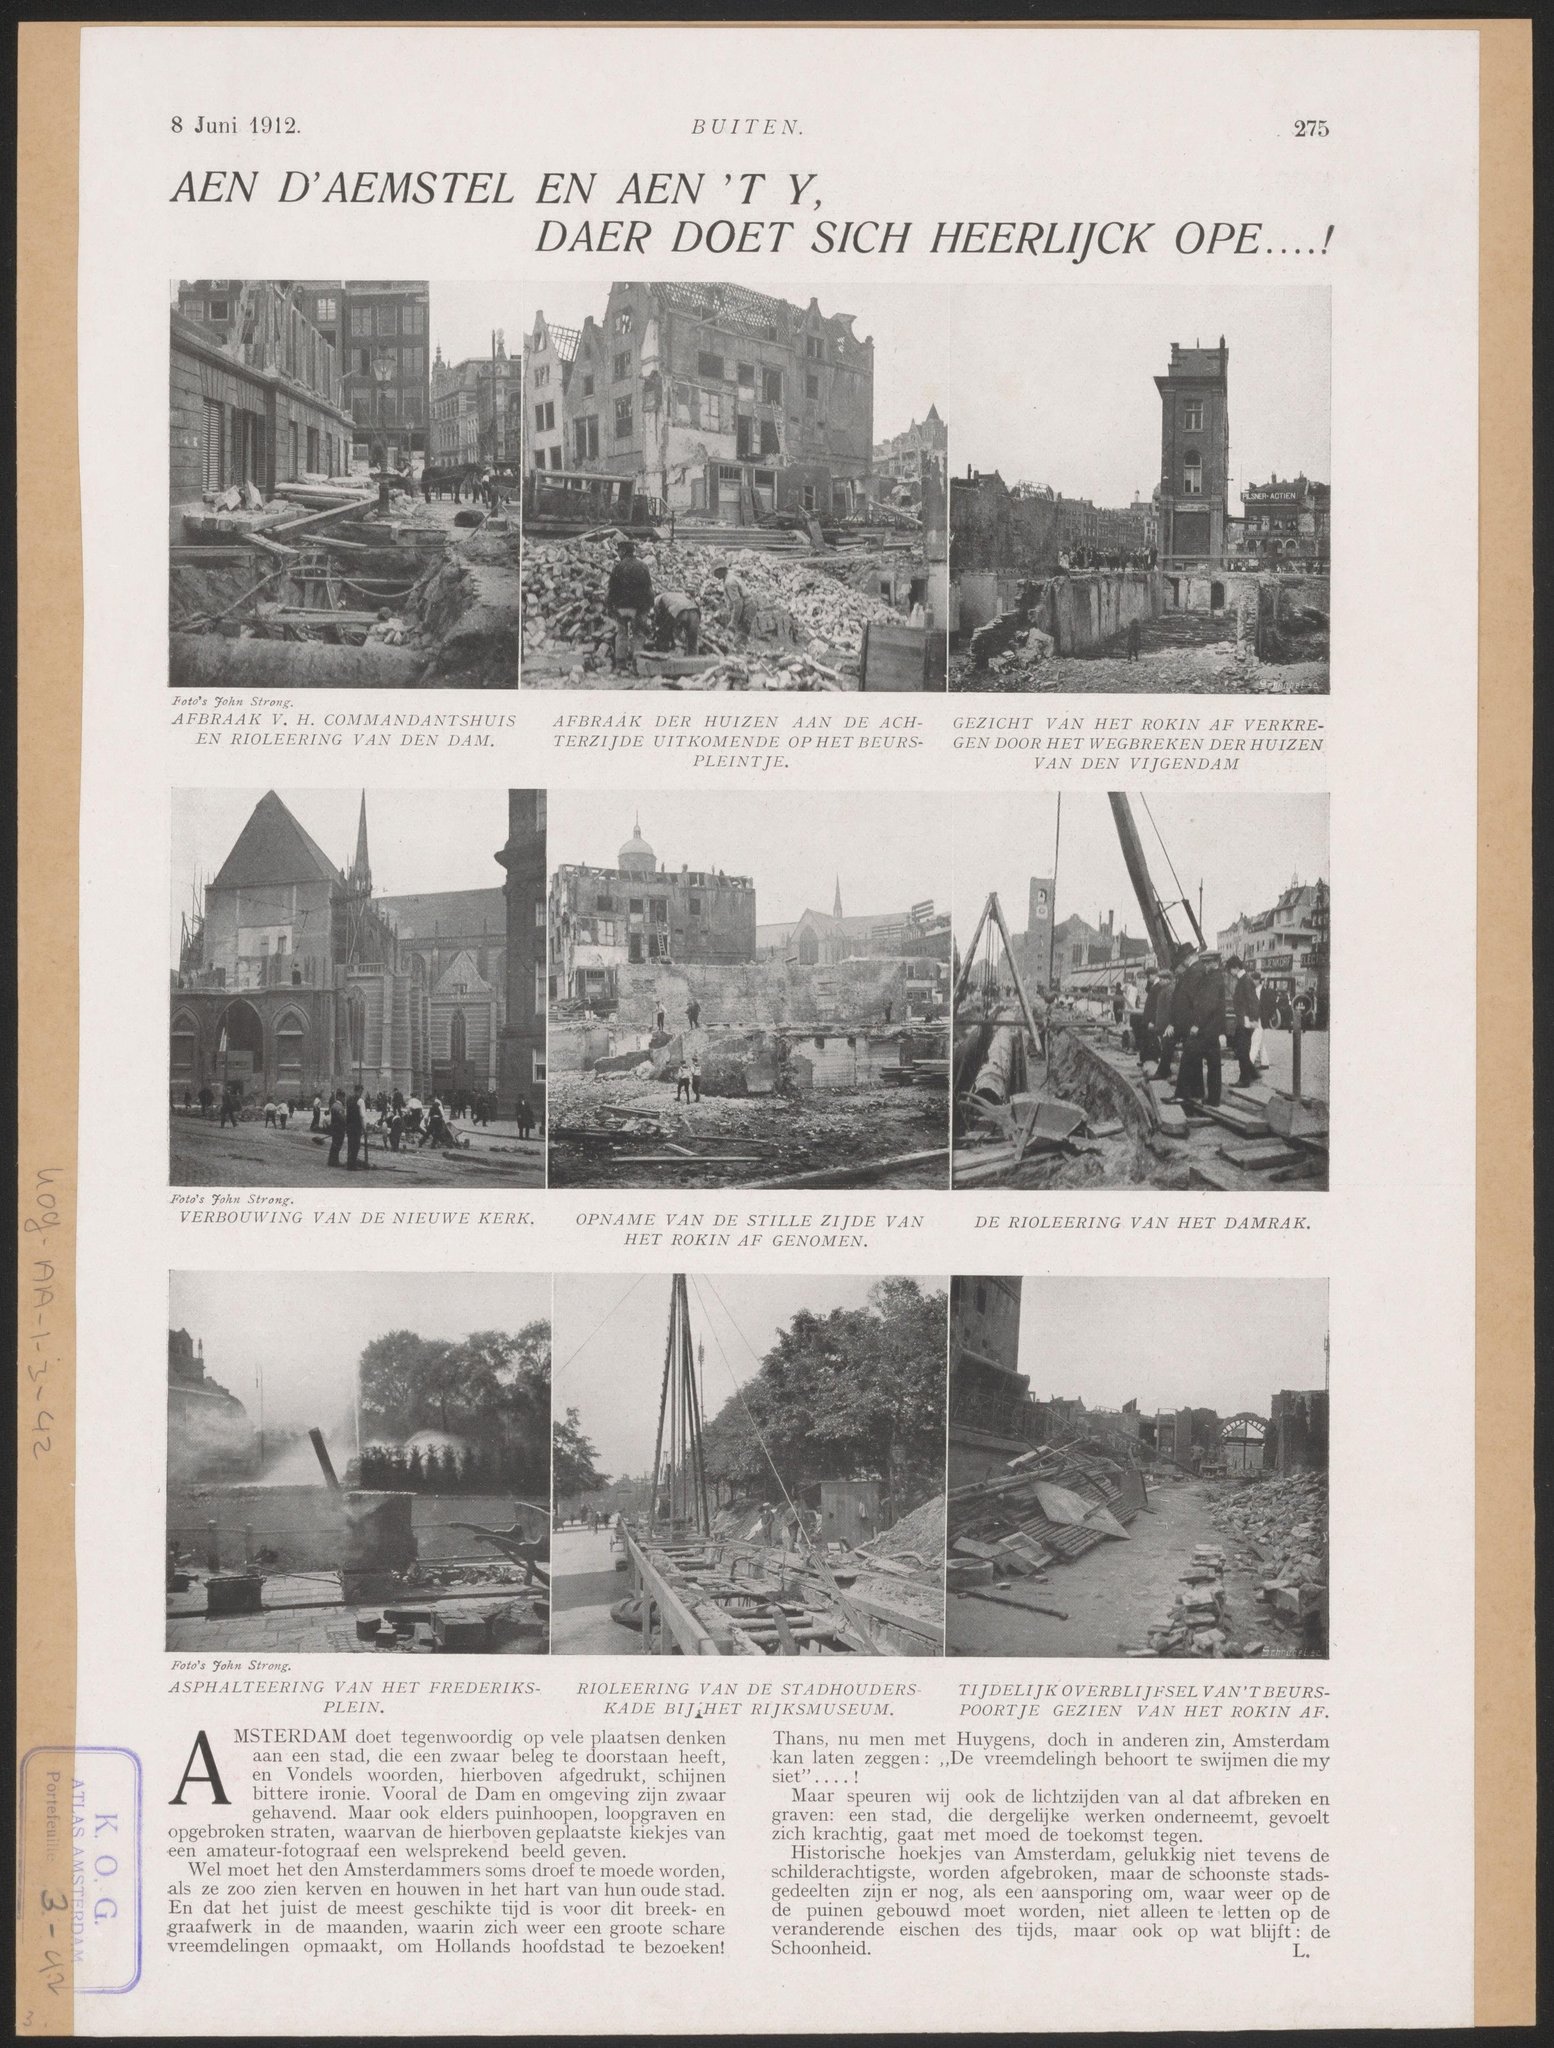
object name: photomechanical print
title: Gezichten op en rondom de Dam en Rokin tijdens de verbouwingen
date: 1912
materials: paper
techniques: letterpress printing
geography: amsterdam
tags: city-view in general; 'veduta', building-site, amsterdam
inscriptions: collector's mark: ‘3-42’ Lugt 1641b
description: Onderwerpsrubriek binnen de Atlas Amsterdam: Panorama's en verzamelprenten.